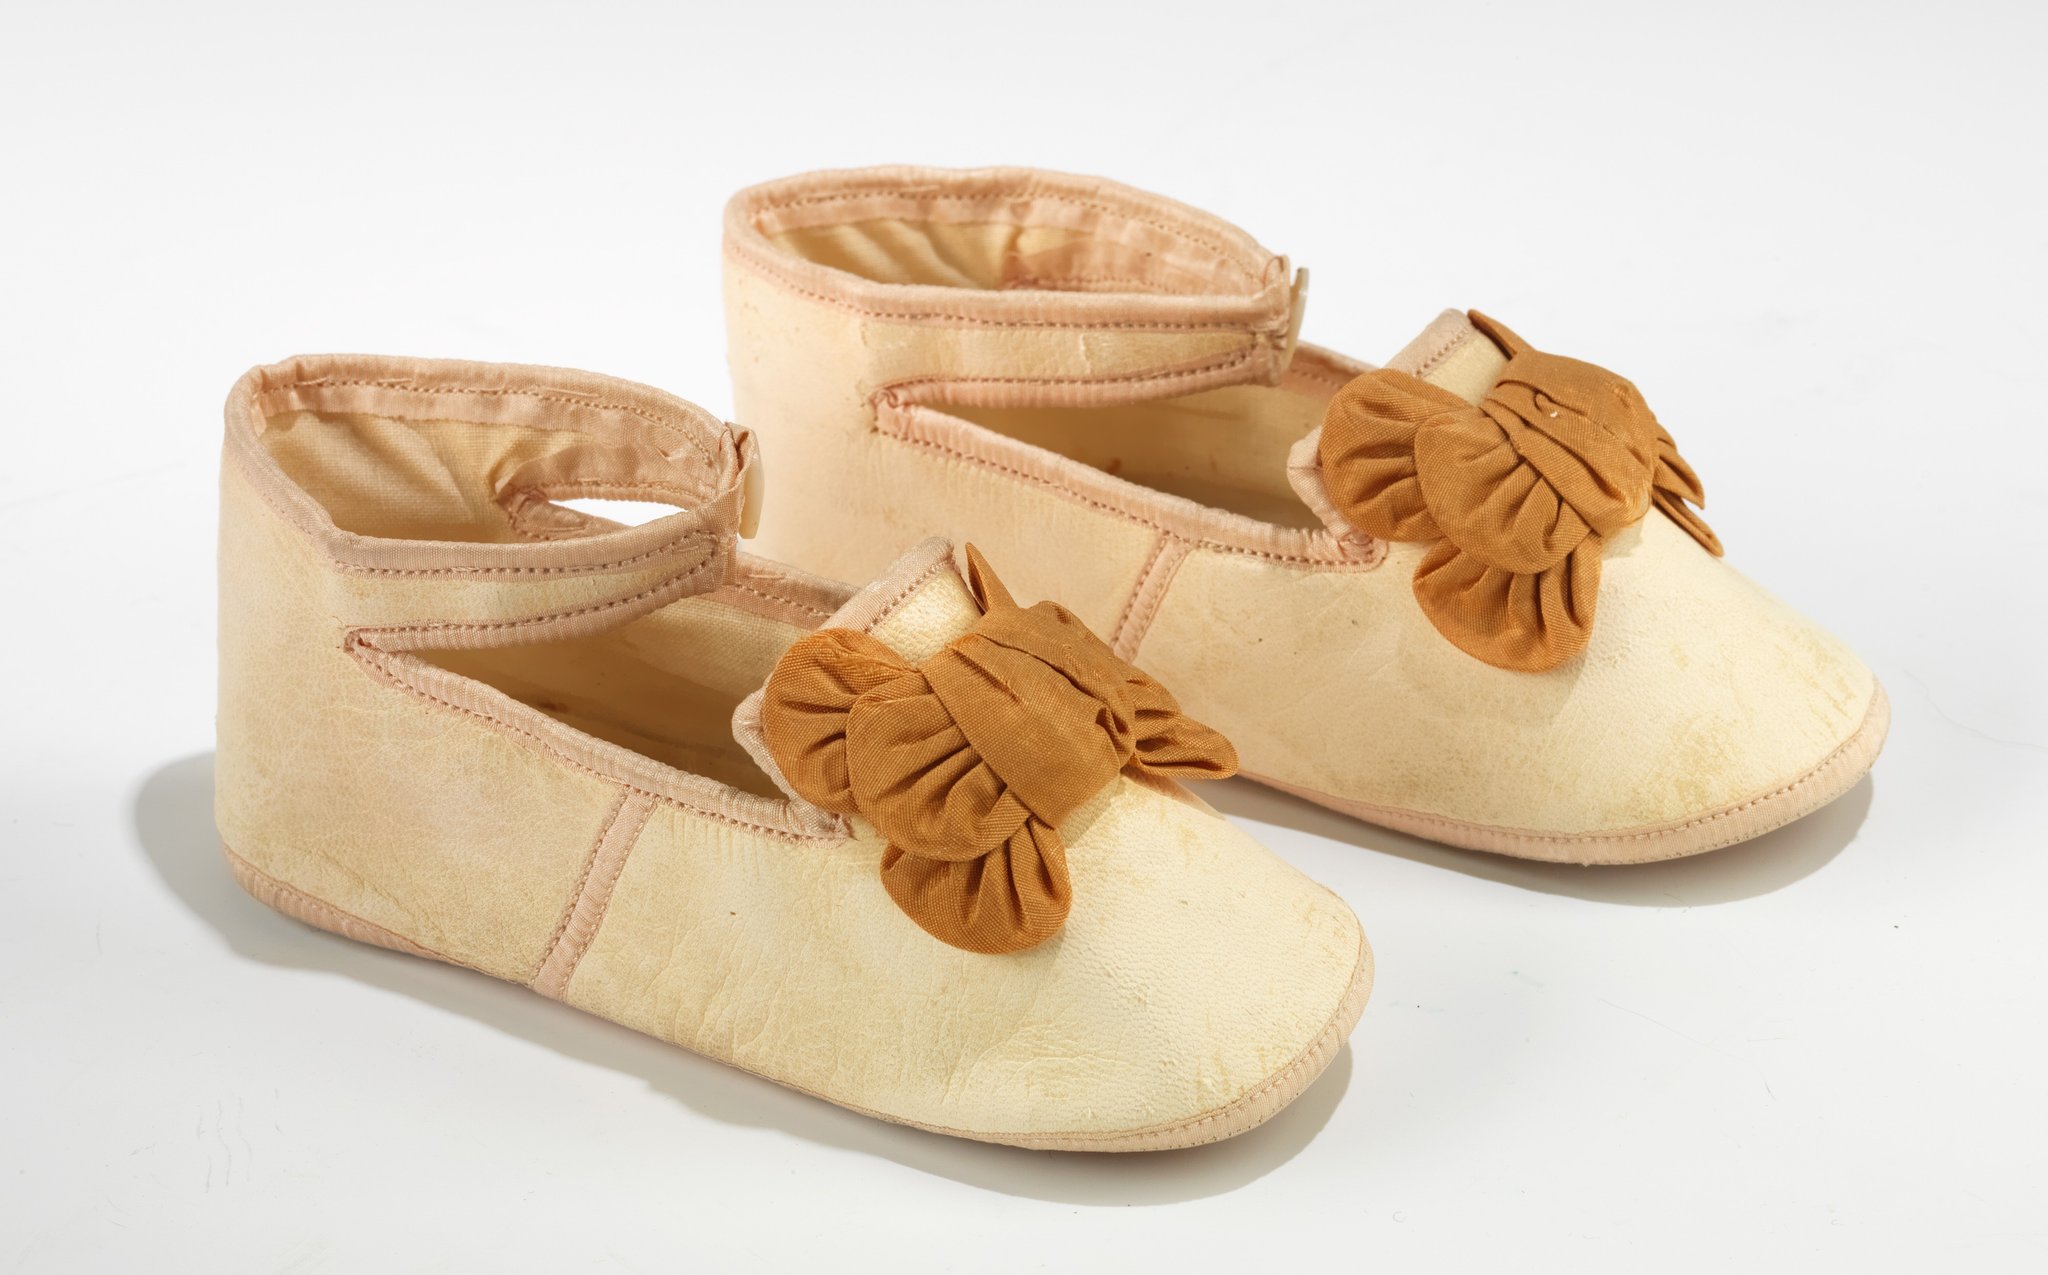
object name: shoe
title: Shoes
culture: french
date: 1875-1895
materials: leather